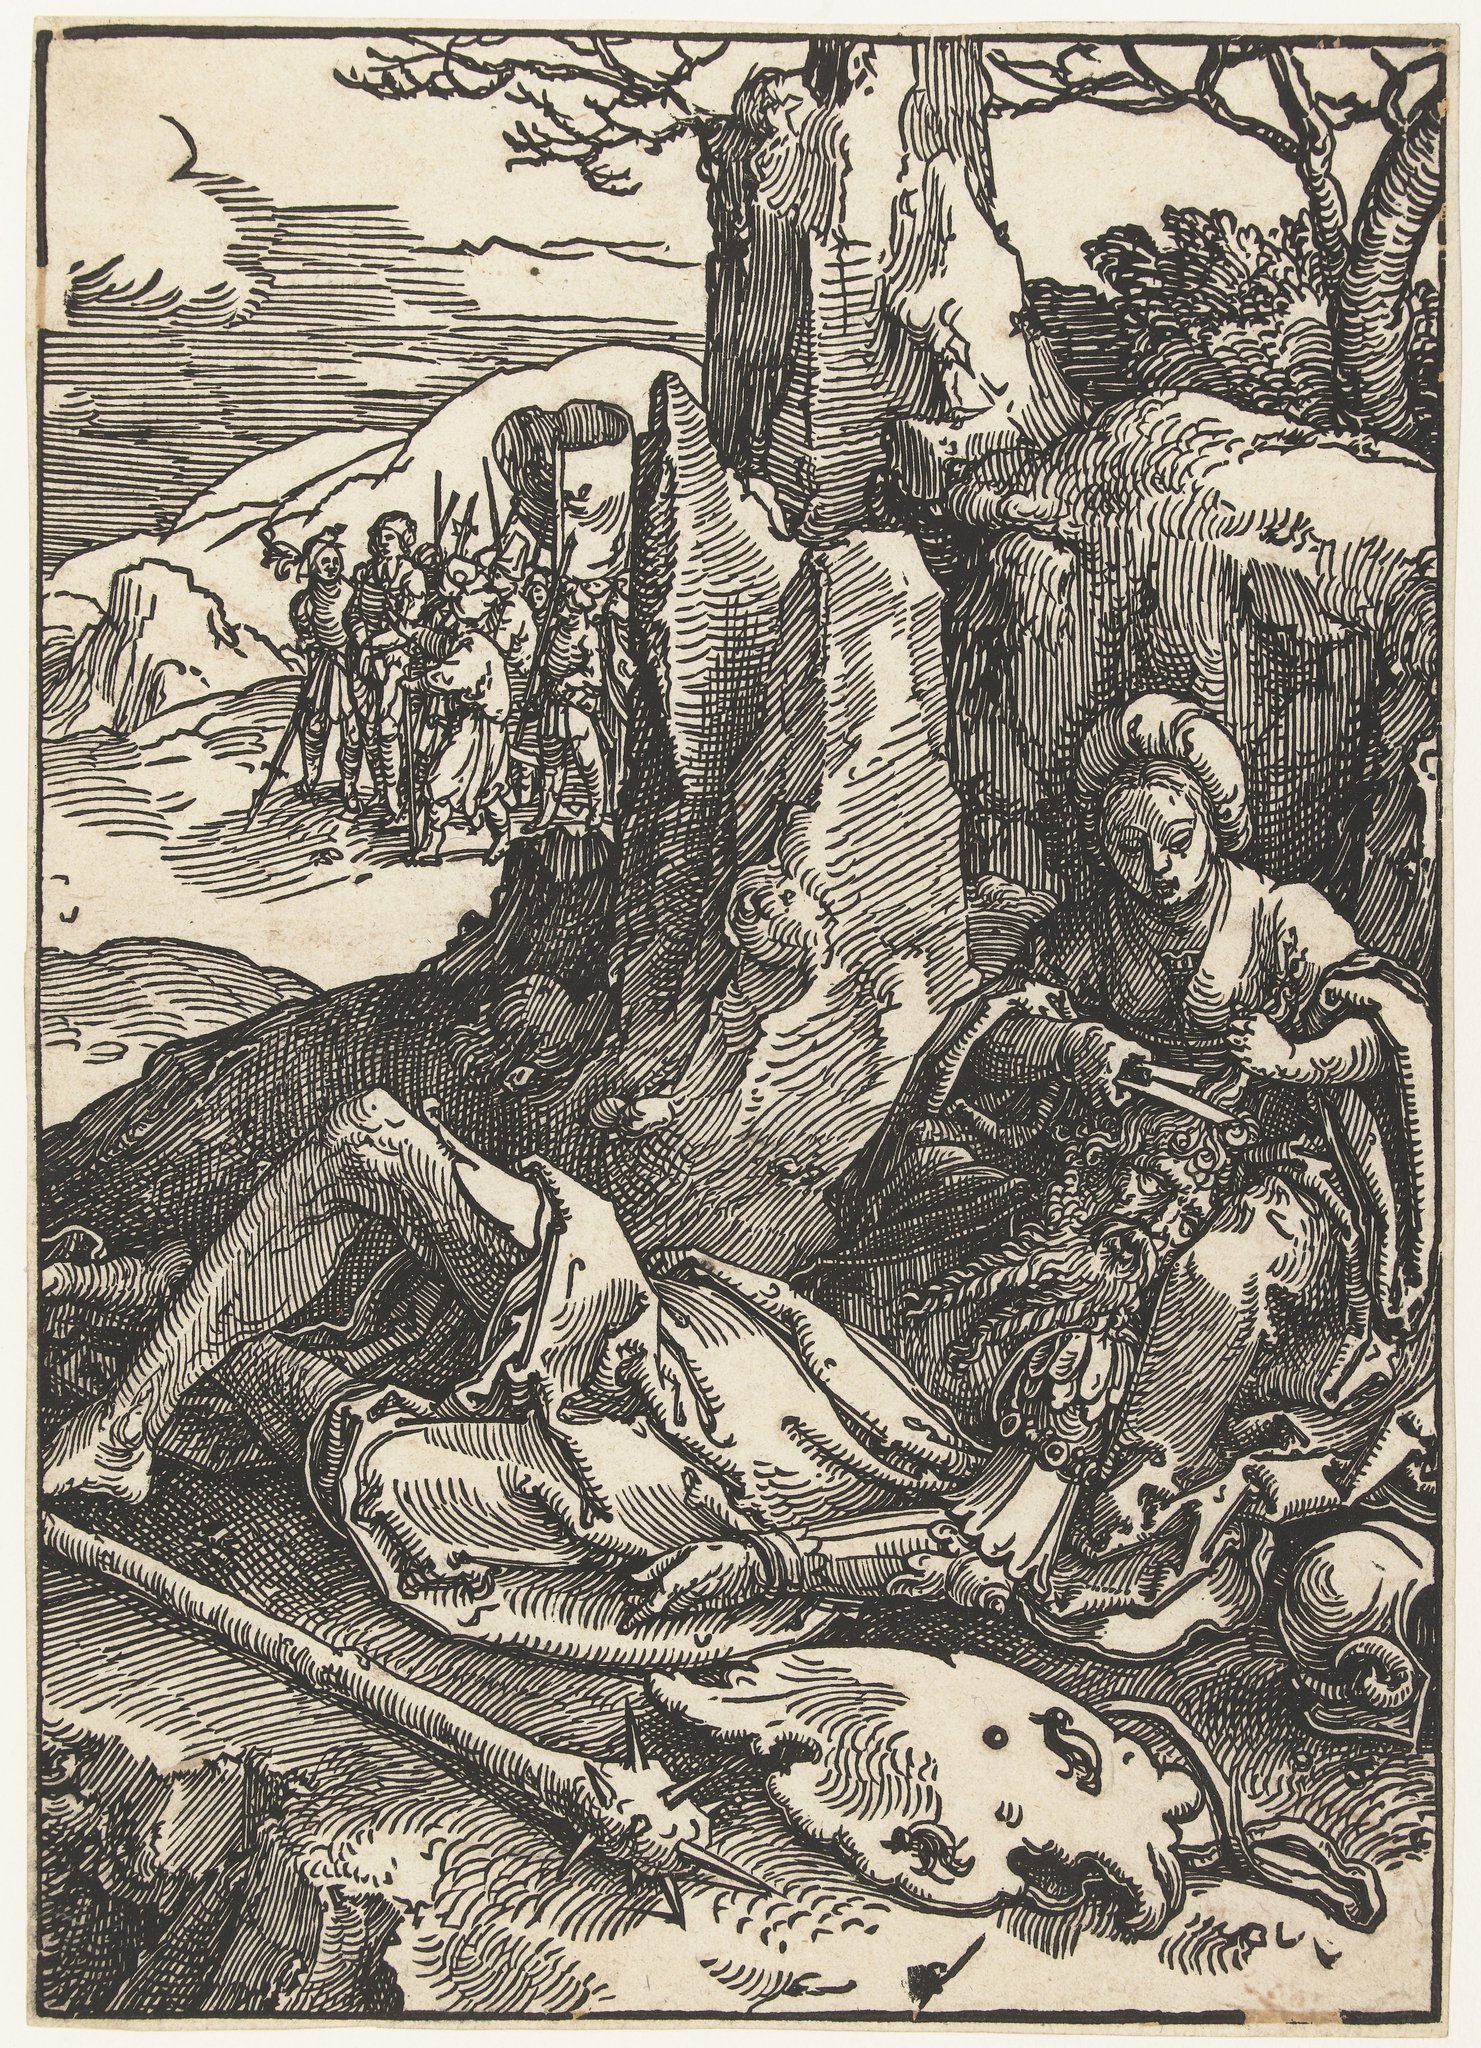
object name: print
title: Simson en Delila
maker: lucas van leyden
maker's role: draughtsman, painter, print maker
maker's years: 1494-1533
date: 1515-1519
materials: paper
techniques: woodcut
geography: low countries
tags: samson's hairlocks are cut off by delilah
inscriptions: collector's mark: Lugt 240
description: Delila knipt de haren van de slapende Simson.